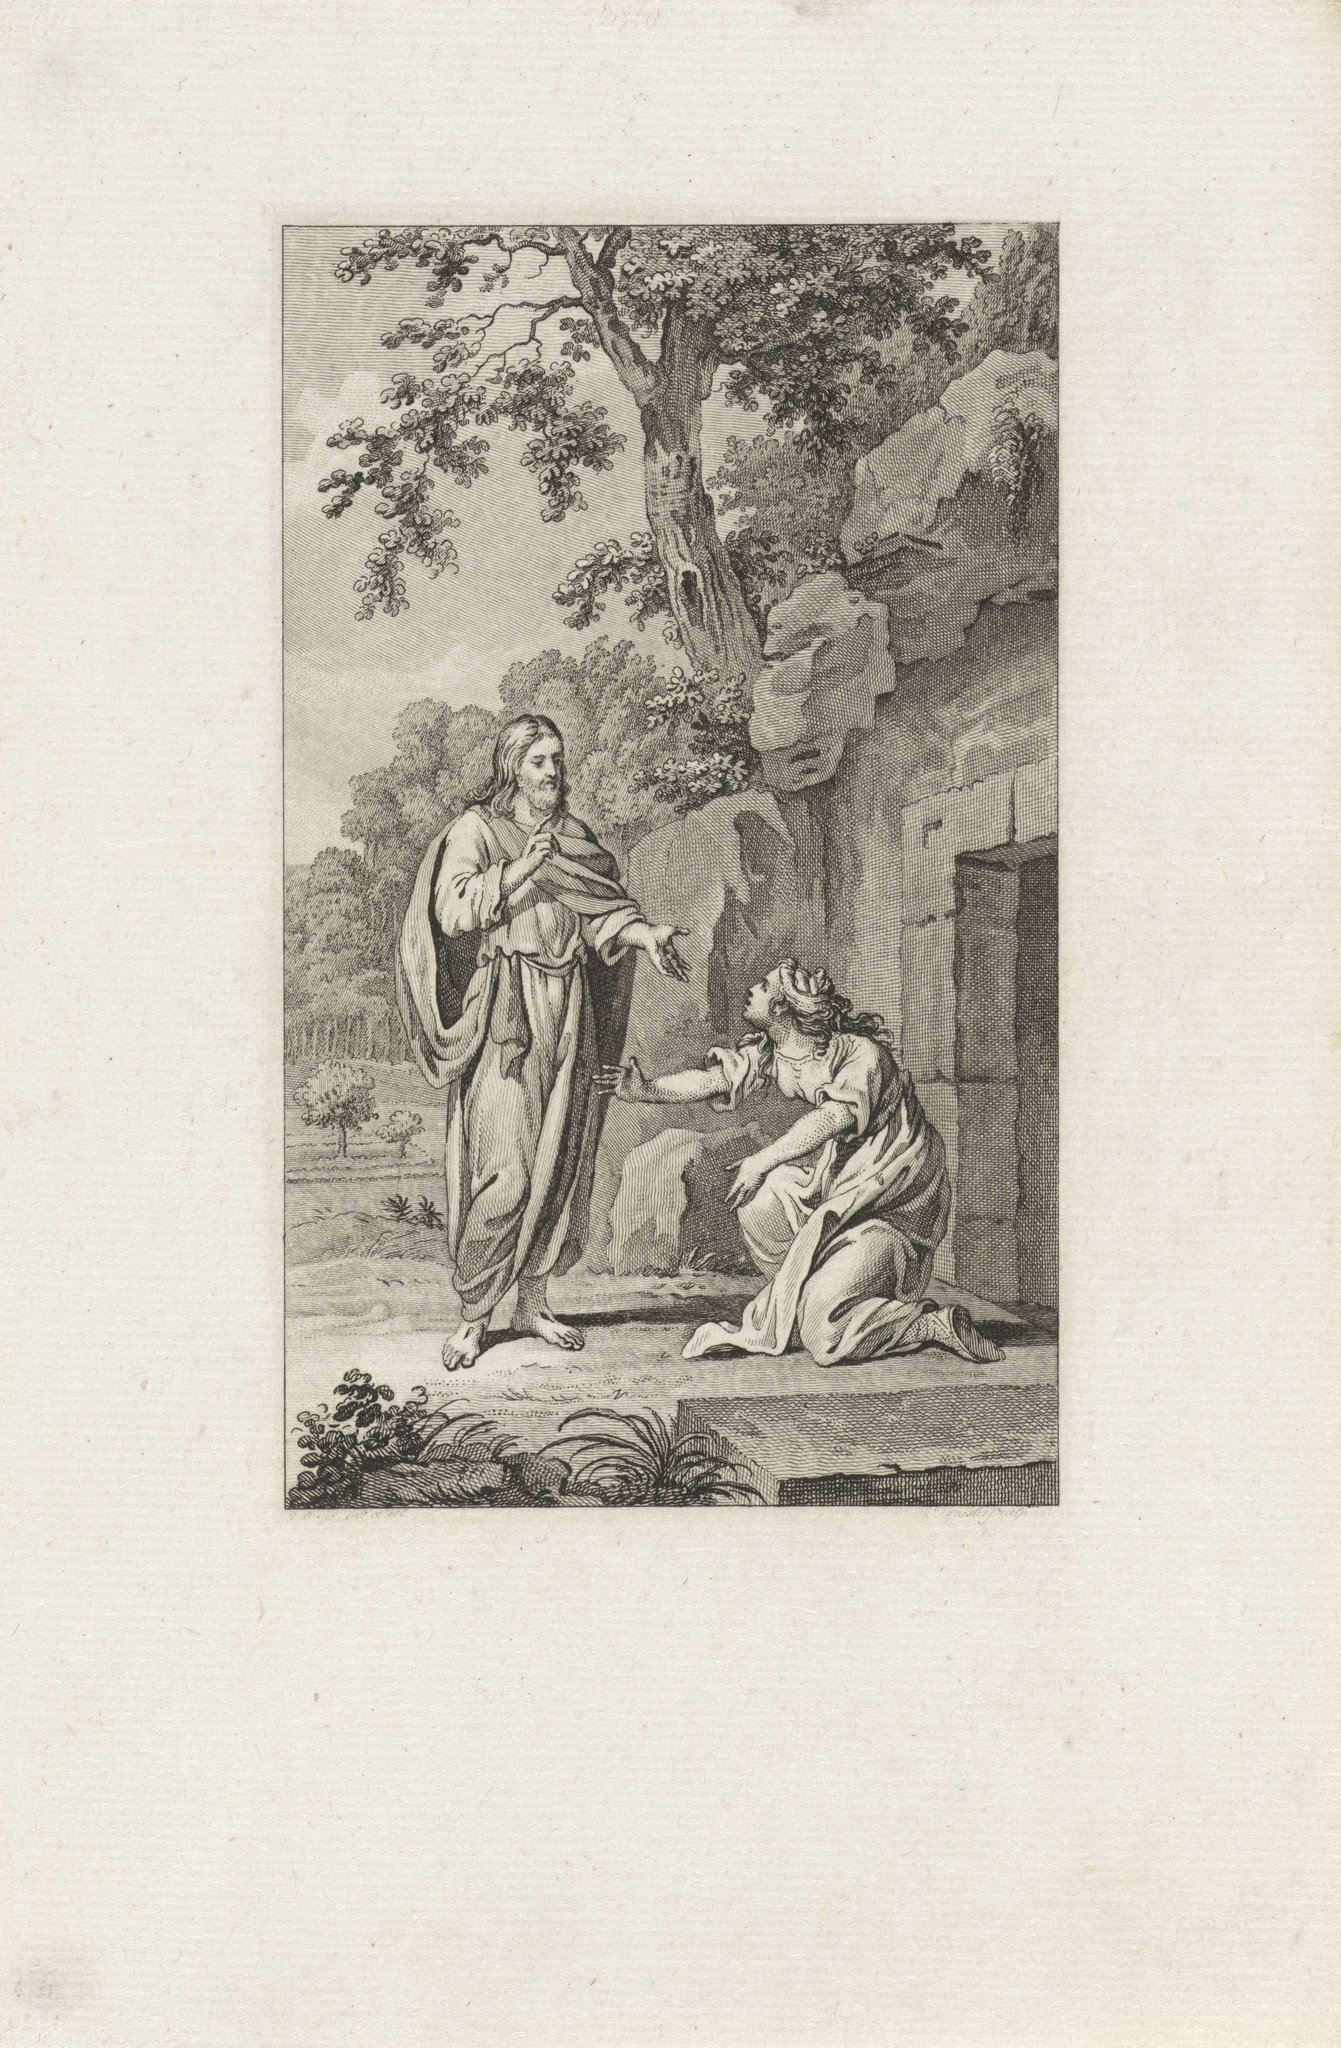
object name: print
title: Christus verschijnt aan Maria Magdalena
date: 1797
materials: paper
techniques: engraving, etching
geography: amsterdam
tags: mary magdalene kneeling before christ, who is usually represented as a gardener with a hoe and/or a spade; 'noli me tangere'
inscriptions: collector's mark: Lugt 240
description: Na de Opstandig verschijnt Christus aan Maria Magdalena. Zijn kruiswonden zijn zichtbaar. Maria Magdalena is rechts voor Christus geknield.